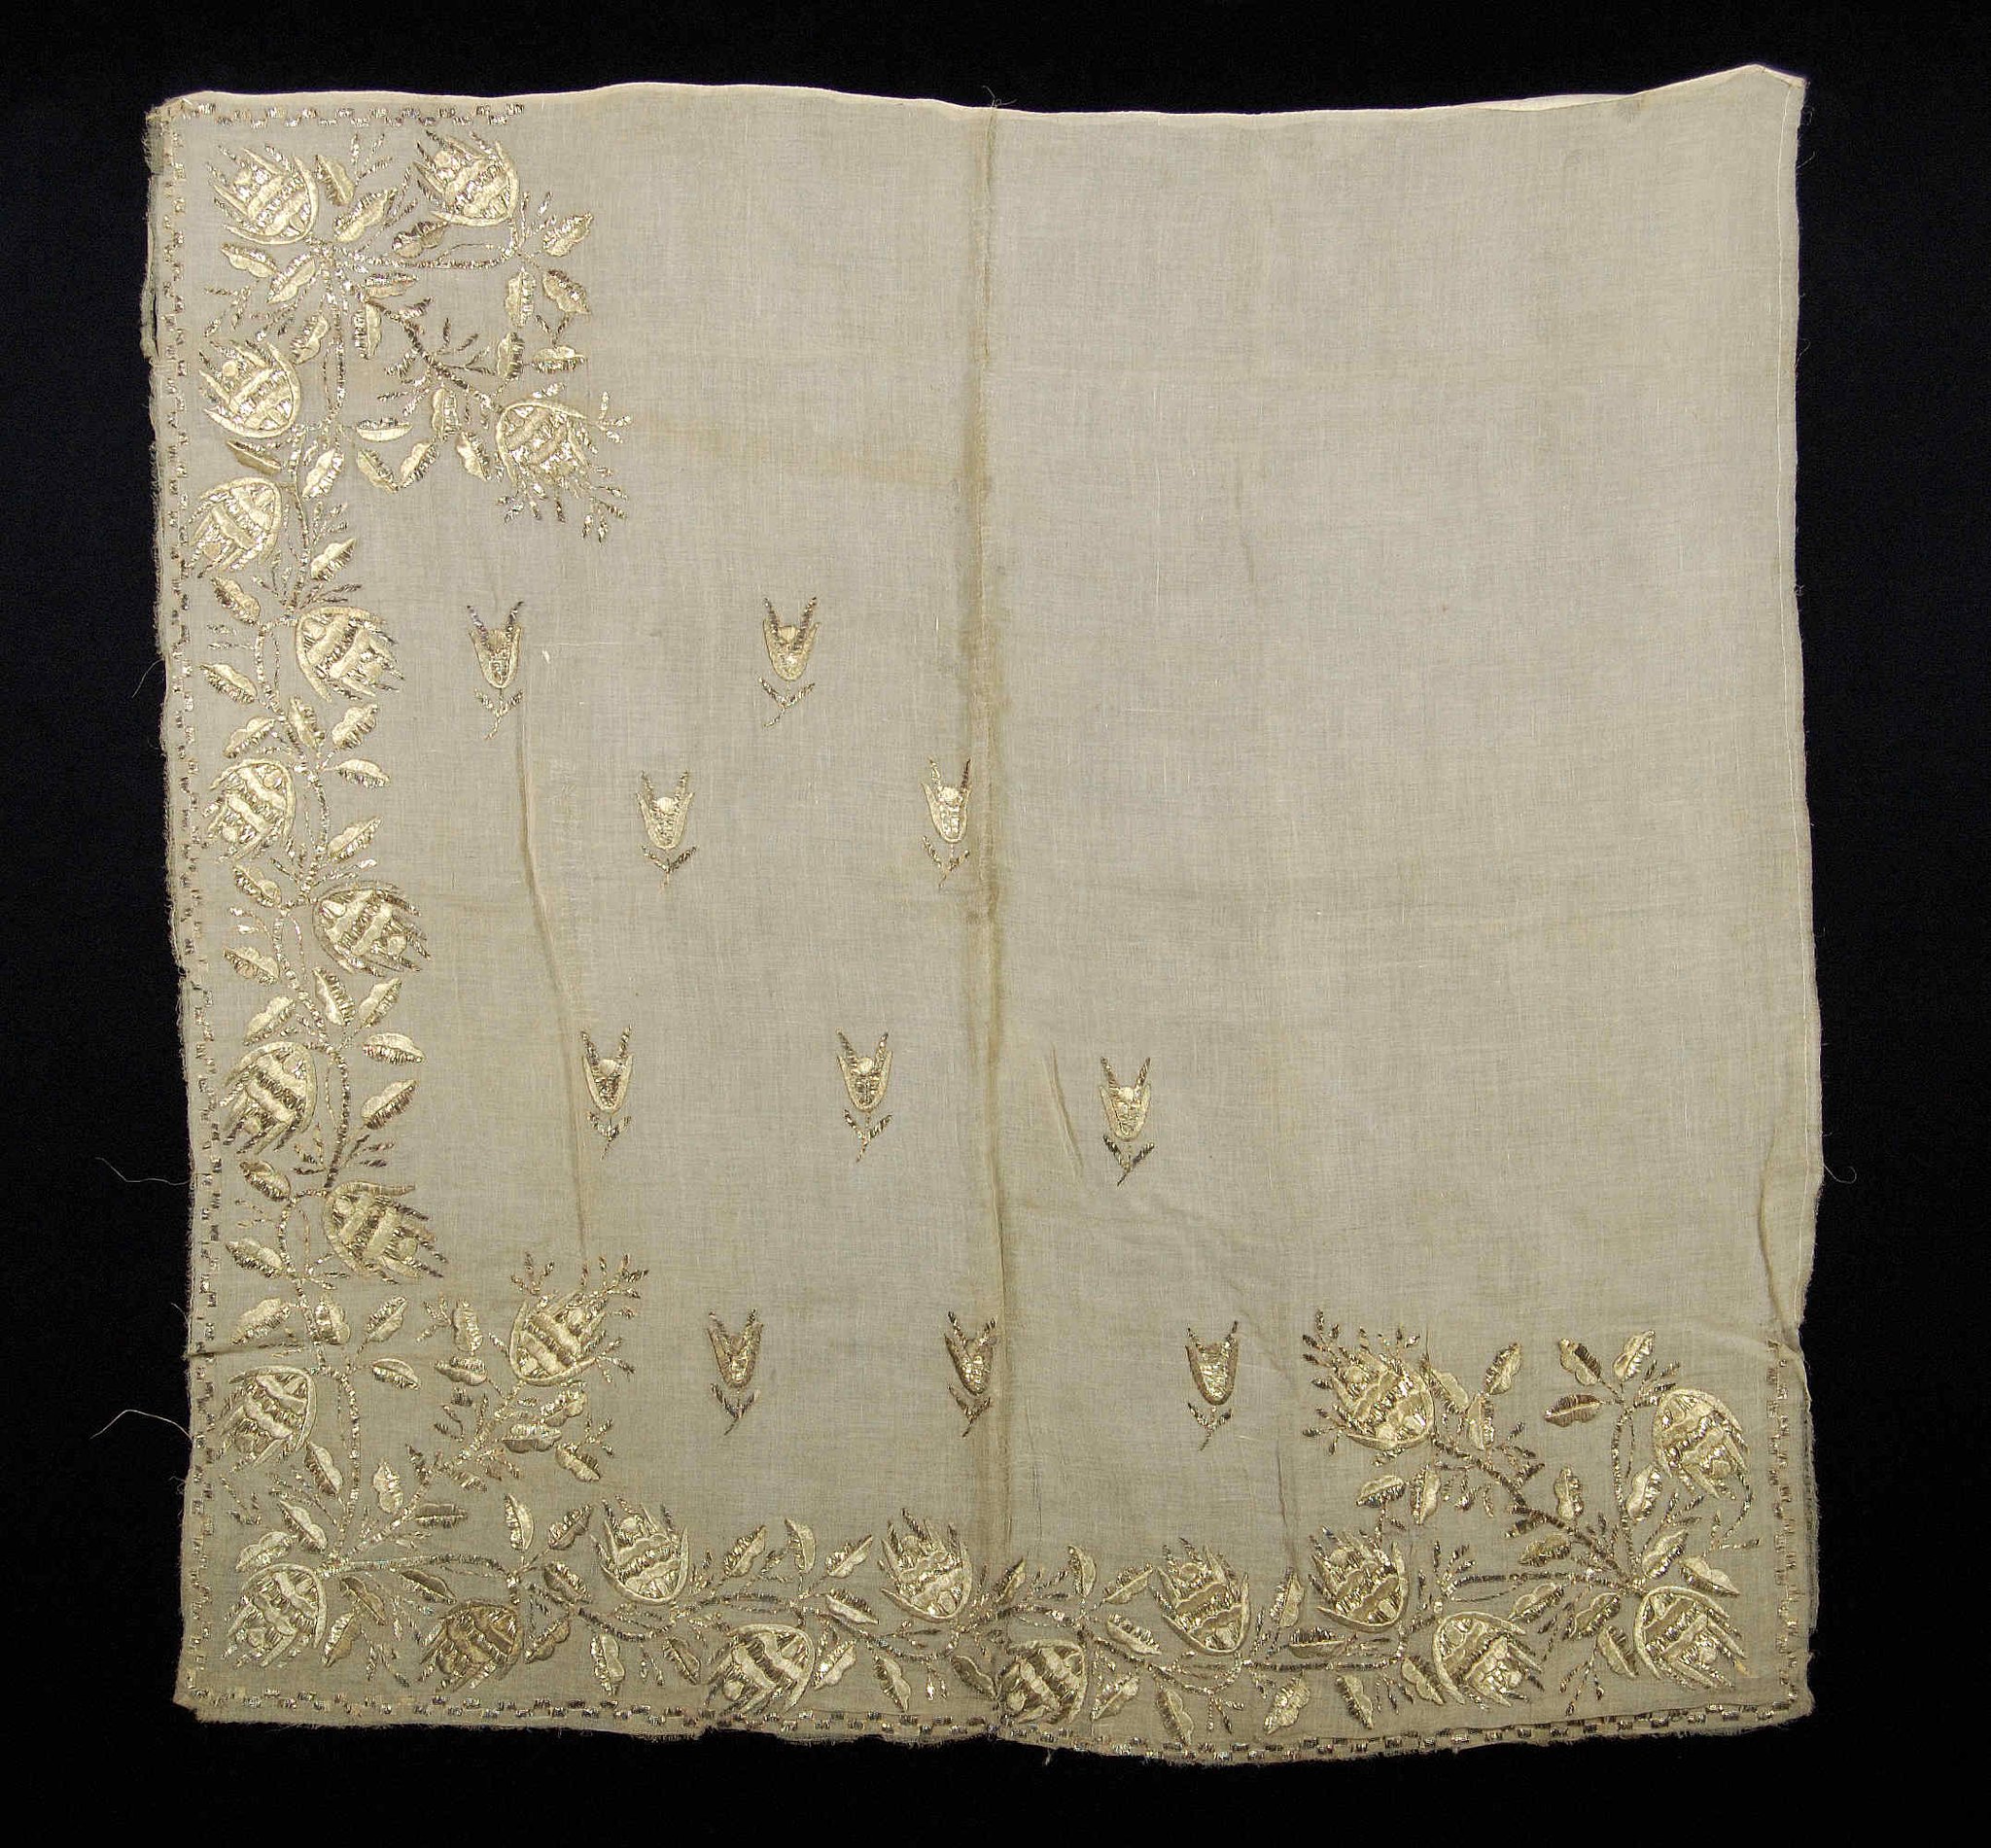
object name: headscarf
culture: russian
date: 1850-1899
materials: cotton, metal